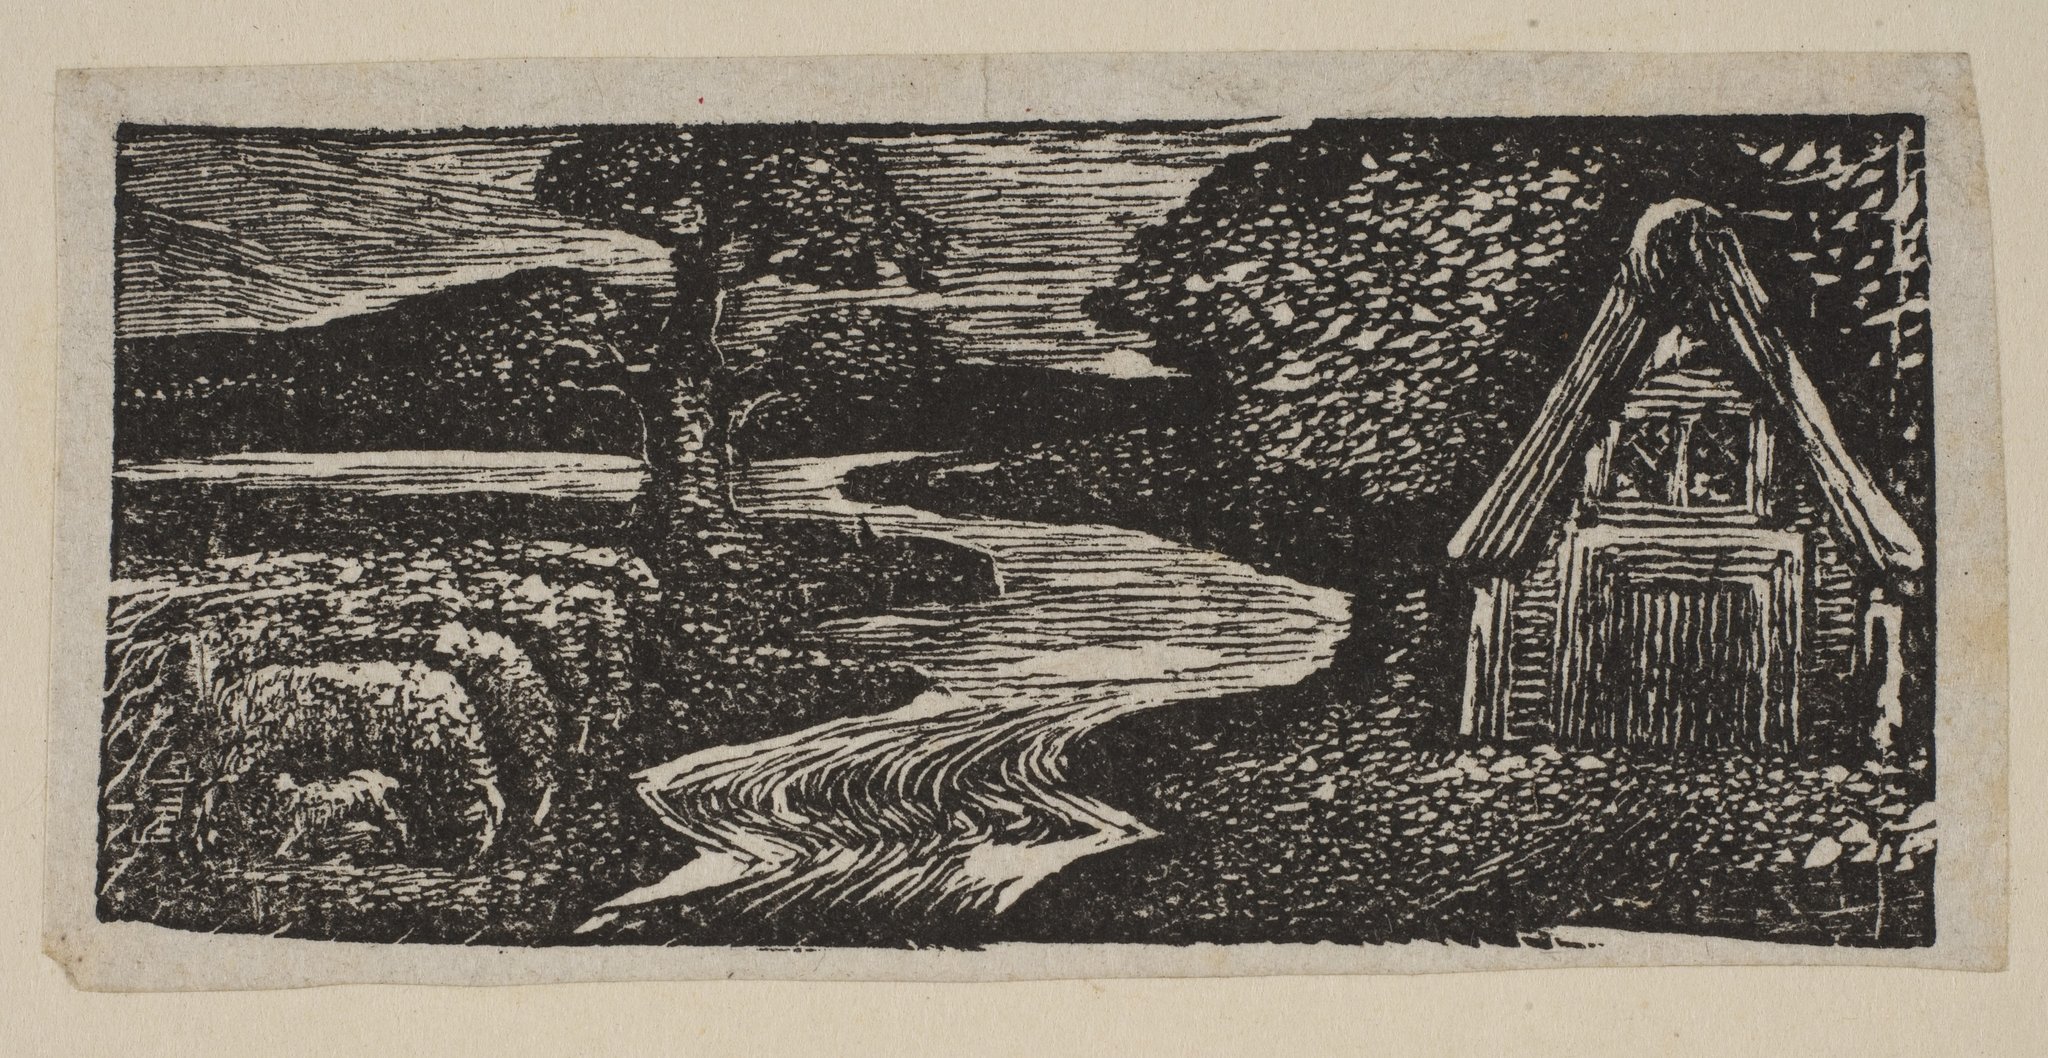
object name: print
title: Sabrina's Silvery Flood, from Thornton's "Pastorals of Virgil"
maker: william blake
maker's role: artist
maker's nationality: british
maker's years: 1757-1827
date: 1821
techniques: engraving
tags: houses,sheep,floods,trees